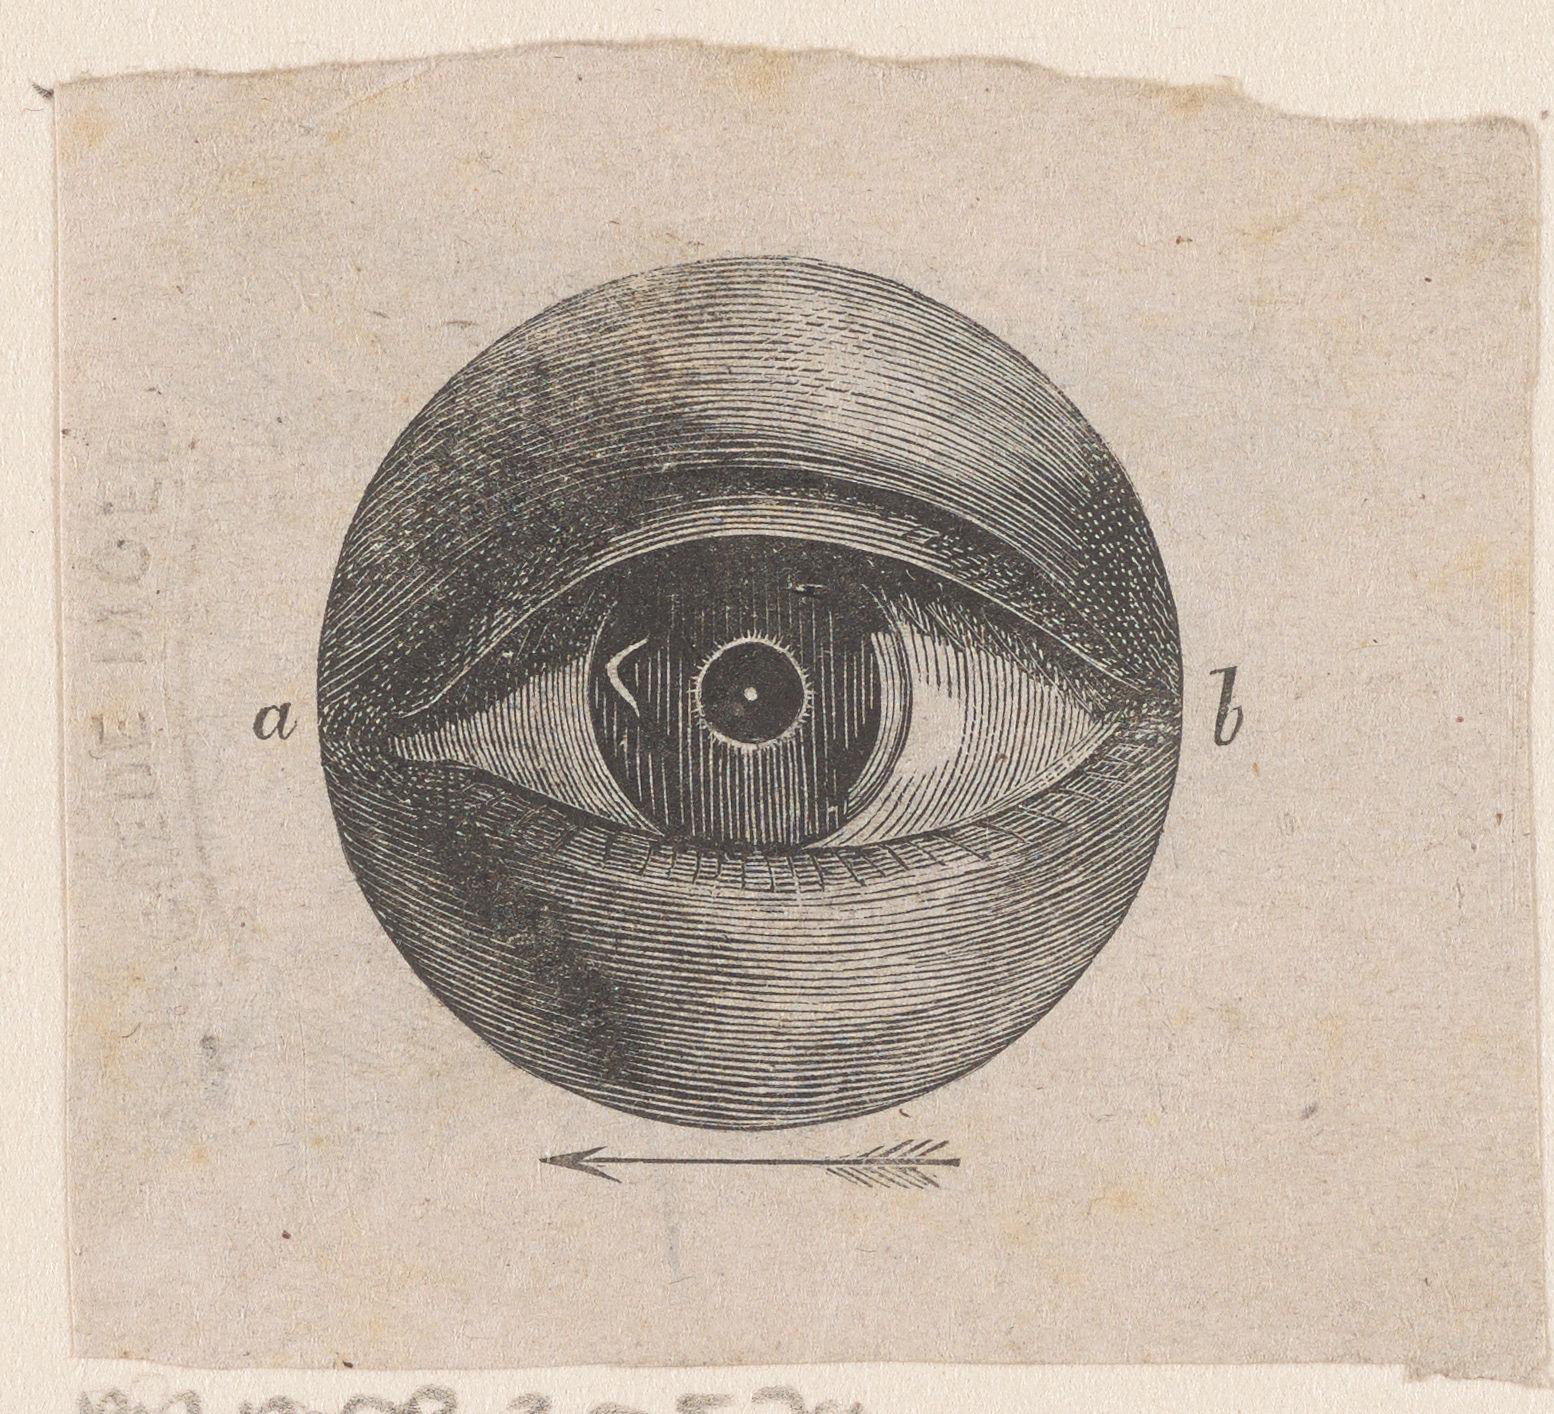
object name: print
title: Menselijk oog met een afwijking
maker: isaac weissenbruch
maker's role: print maker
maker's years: 1826-1912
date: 1836-1912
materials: paper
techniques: engraving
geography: netherlands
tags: eyes, diseases